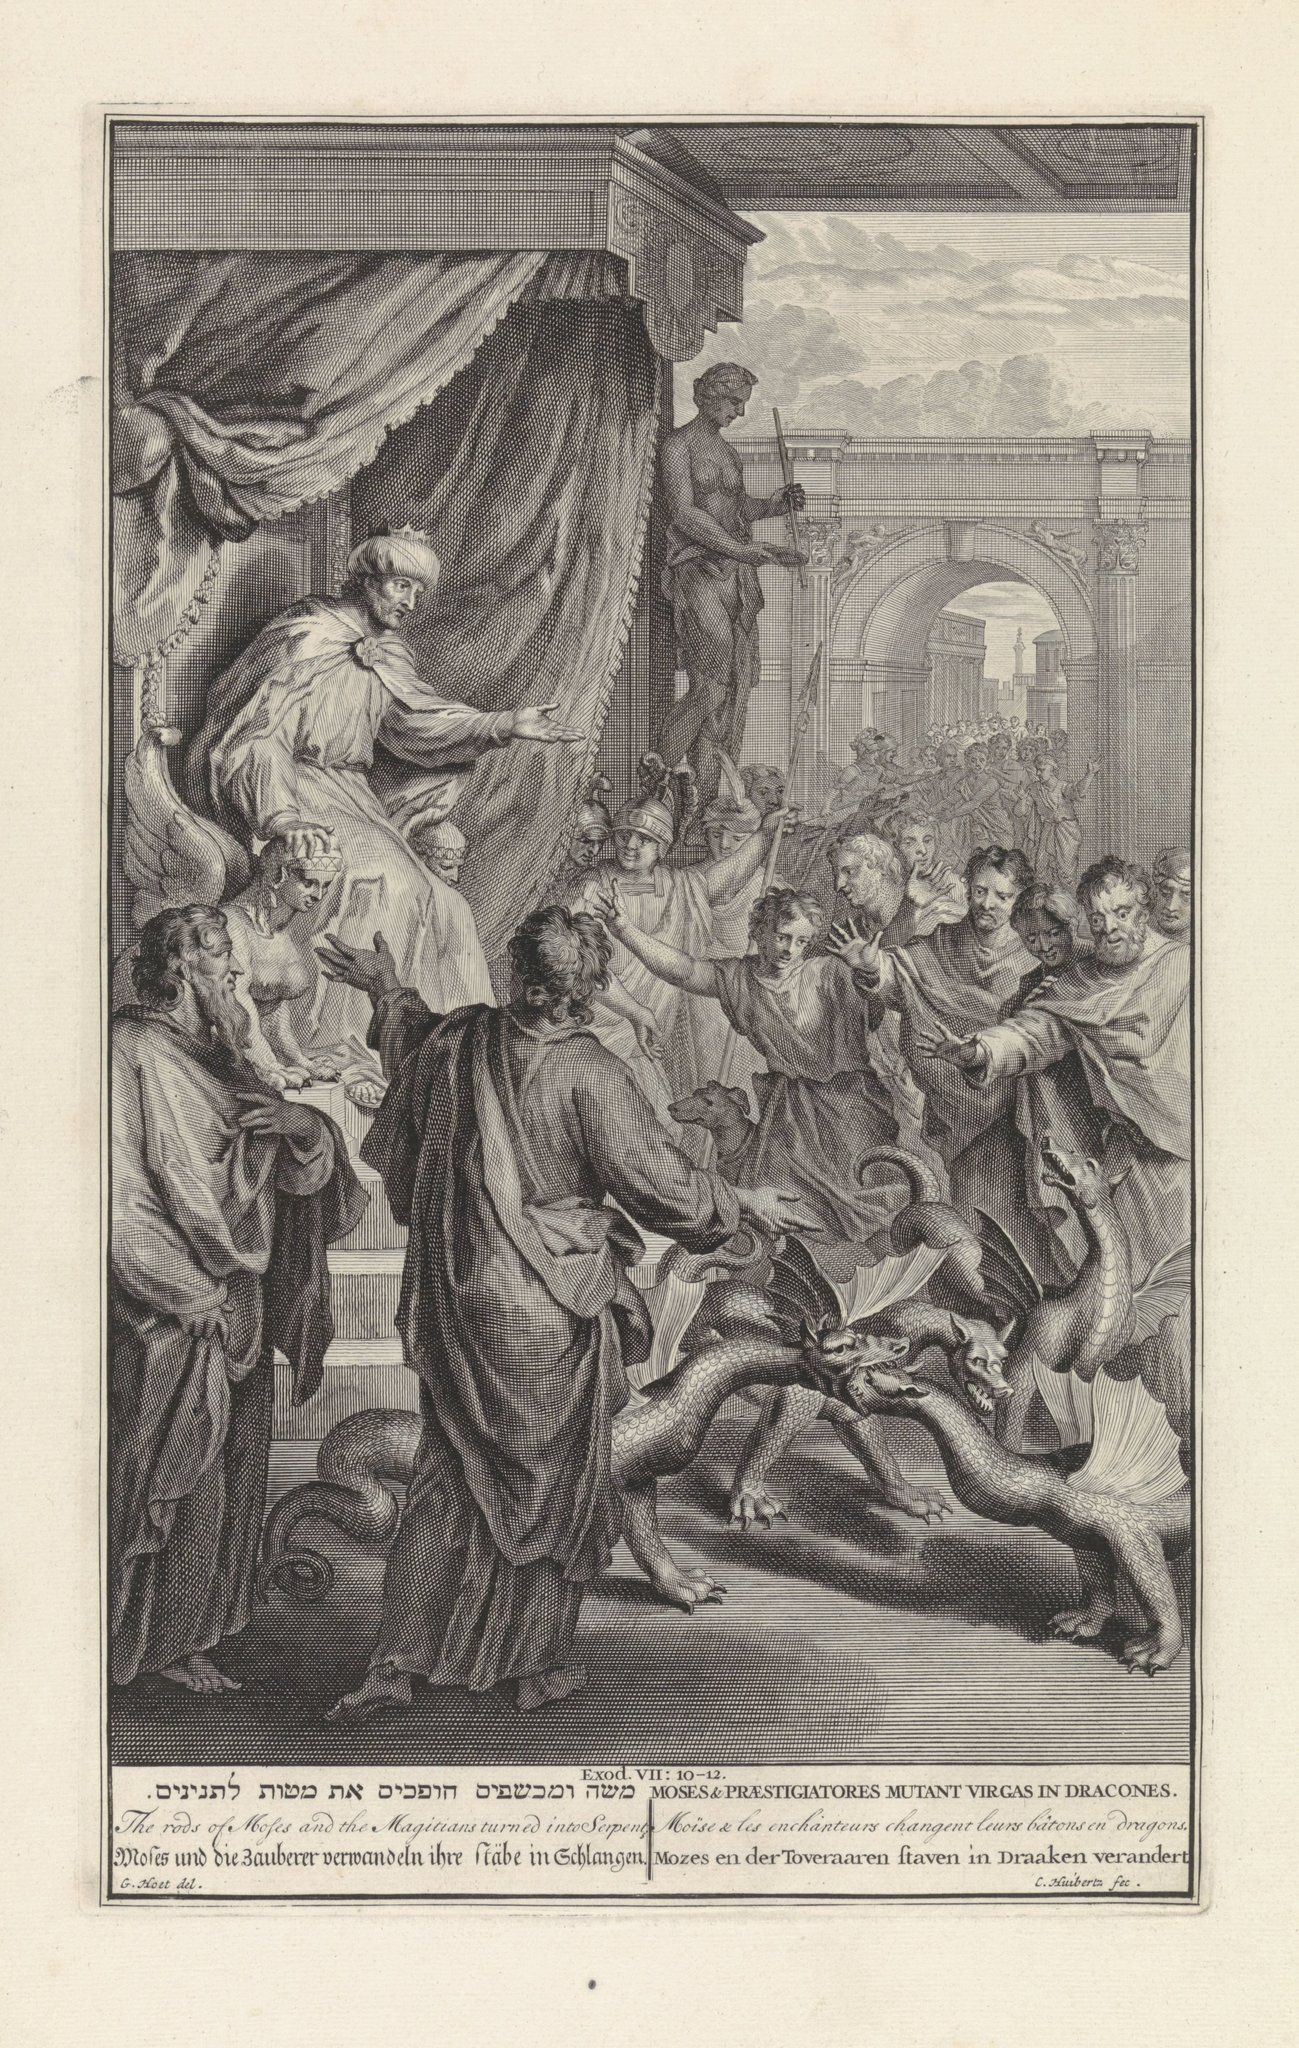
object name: book illustration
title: Mozes en Aäron bij farao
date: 1720-1728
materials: paper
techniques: engraving, etching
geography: amsterdam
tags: all the magicians summoned by the king turn their rods into snakes, but aaron's rod swallows them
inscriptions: inscription: ‘Utrechts Fundatie Huijs’, collector's mark: Lugt 2228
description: Mozes en Aäron links op de voorgrond, één van hen op de rug gezien. Farao zit op zijn troon onder een baldakijn. De staf van Aäron en de staven van farao's tovenaars zijn veranderd in draken of slangen en de staf van Aäron verslindt die van de tovenaars. Linksachter een poort, waaronder een mensenmenigte. Onder een verwijzing naar Ex. 7:10-12 en de titel van de prent in Hebreeuws, Engels, Duits, Latijn, Frans en Nederlands.